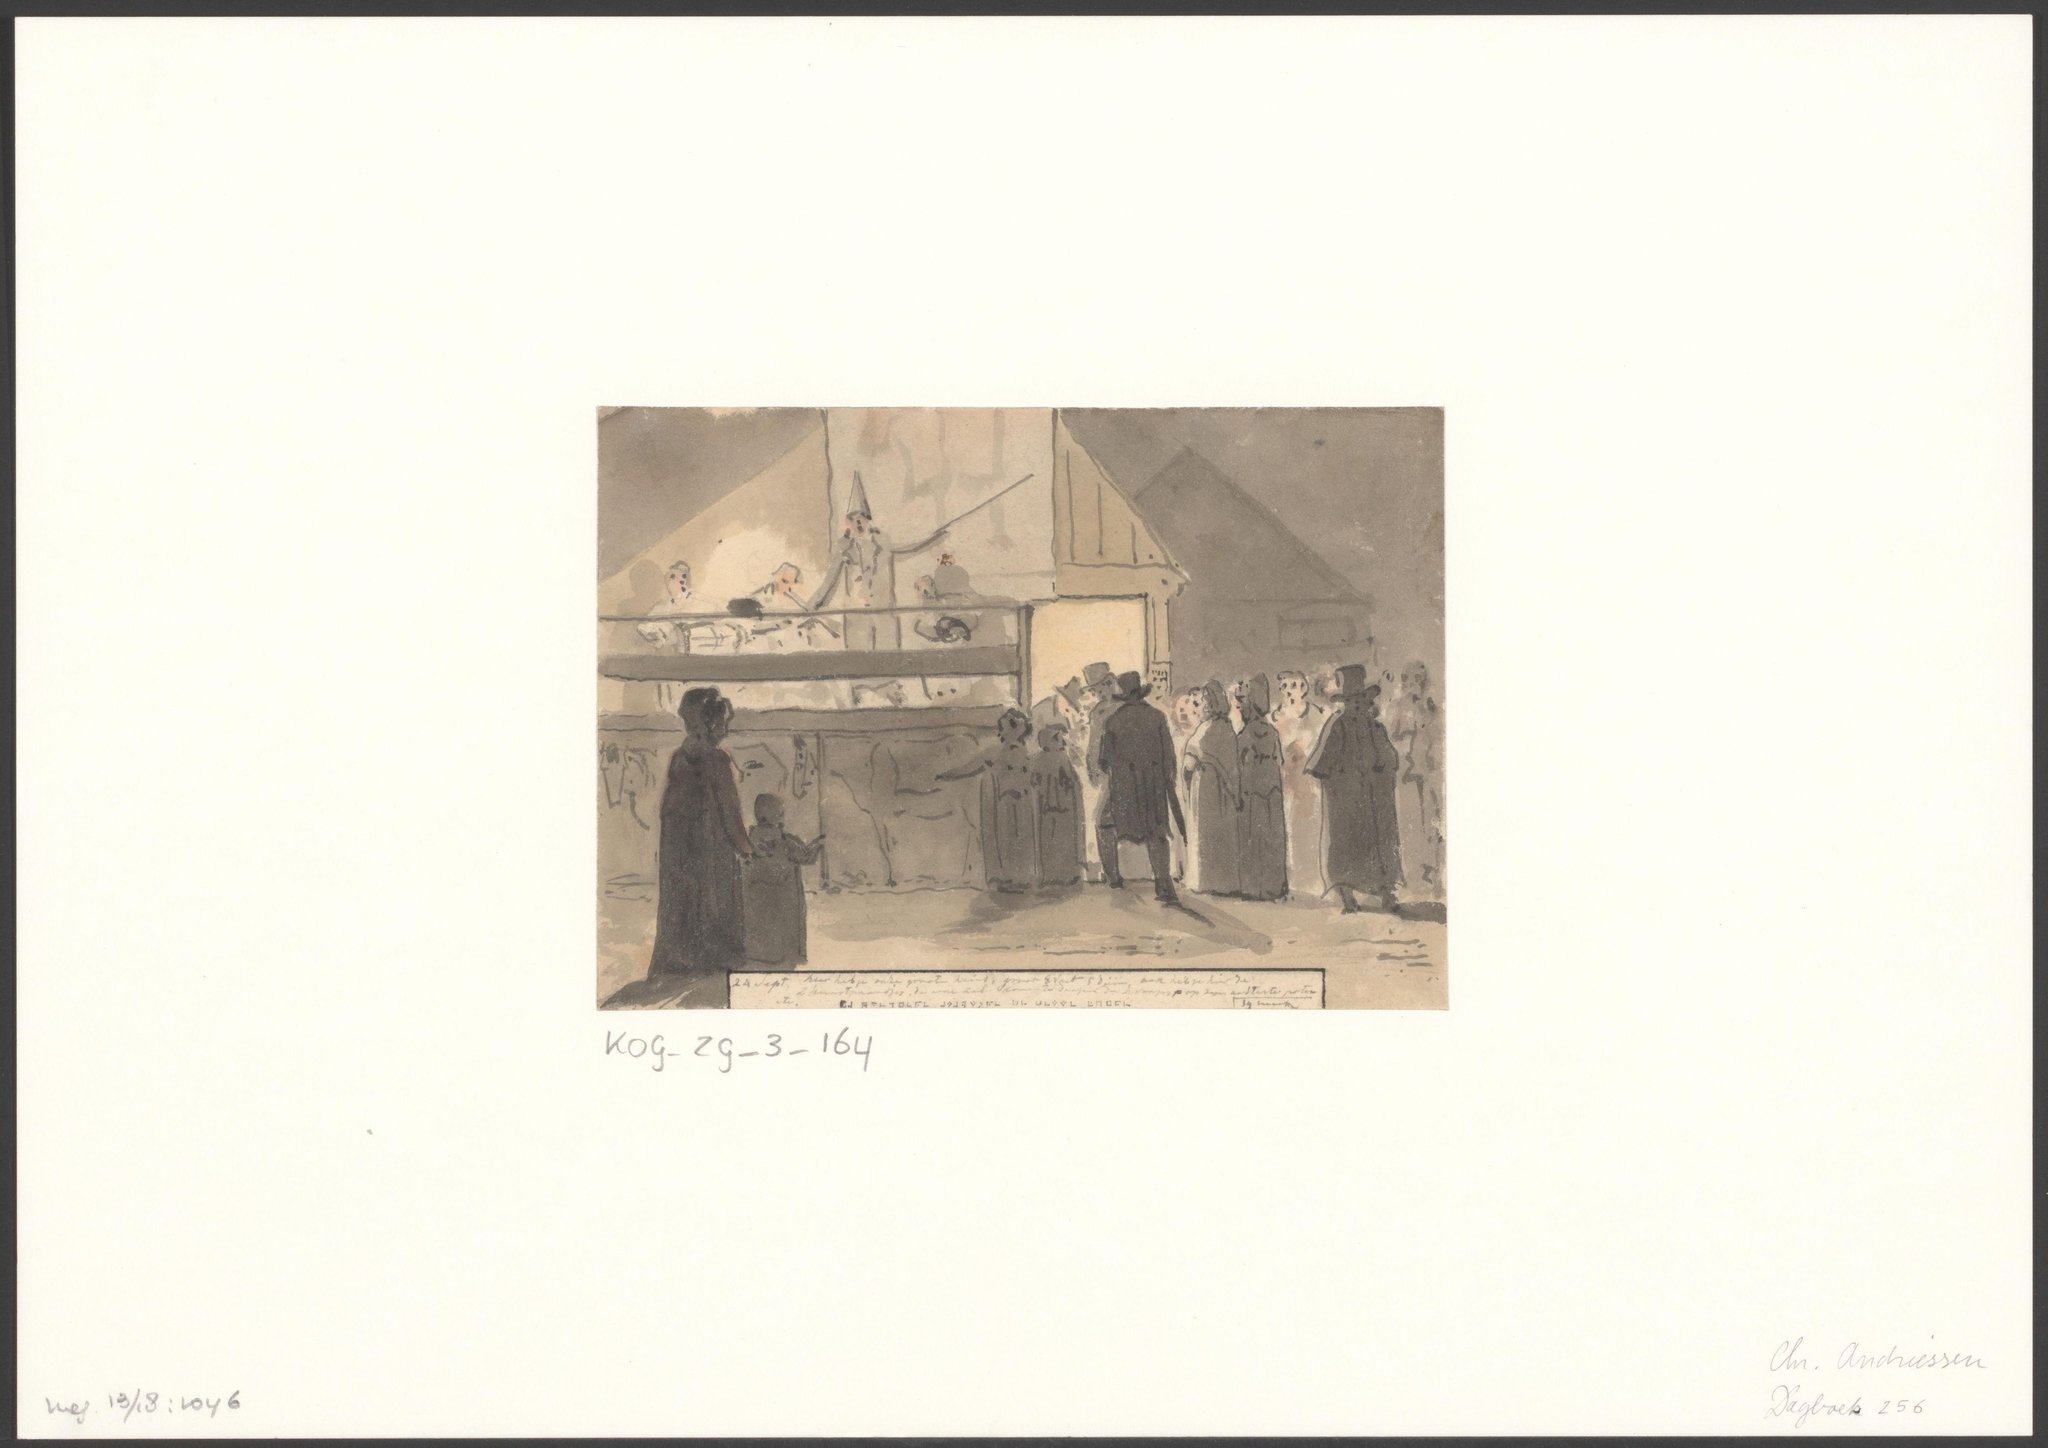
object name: drawing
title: Bezoekers stromen een kermistent binnen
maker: christiaan andriessen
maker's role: draughtsman, print maker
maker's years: 1775-1846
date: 1808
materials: ink, paper, pencil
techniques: brush, pen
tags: amsterdam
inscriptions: inscription: ‘24 Sept Hier heb je onze groote reus, groot 8 voet 5 duijm, ook heb je hier de 2 kunstpaardjes, de eene zal (...) op zijn achterste poten’, collector's mark: Lugt 1641a, collector's mark: Lugt 1641, signature: ‘J Andriessen’, inscription: ‘la premier avanture de cette foire’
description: Dagboekblad uit het getekende dagboek dat Christiaan Andriessen bijhield van 1805 tot en met 1808.